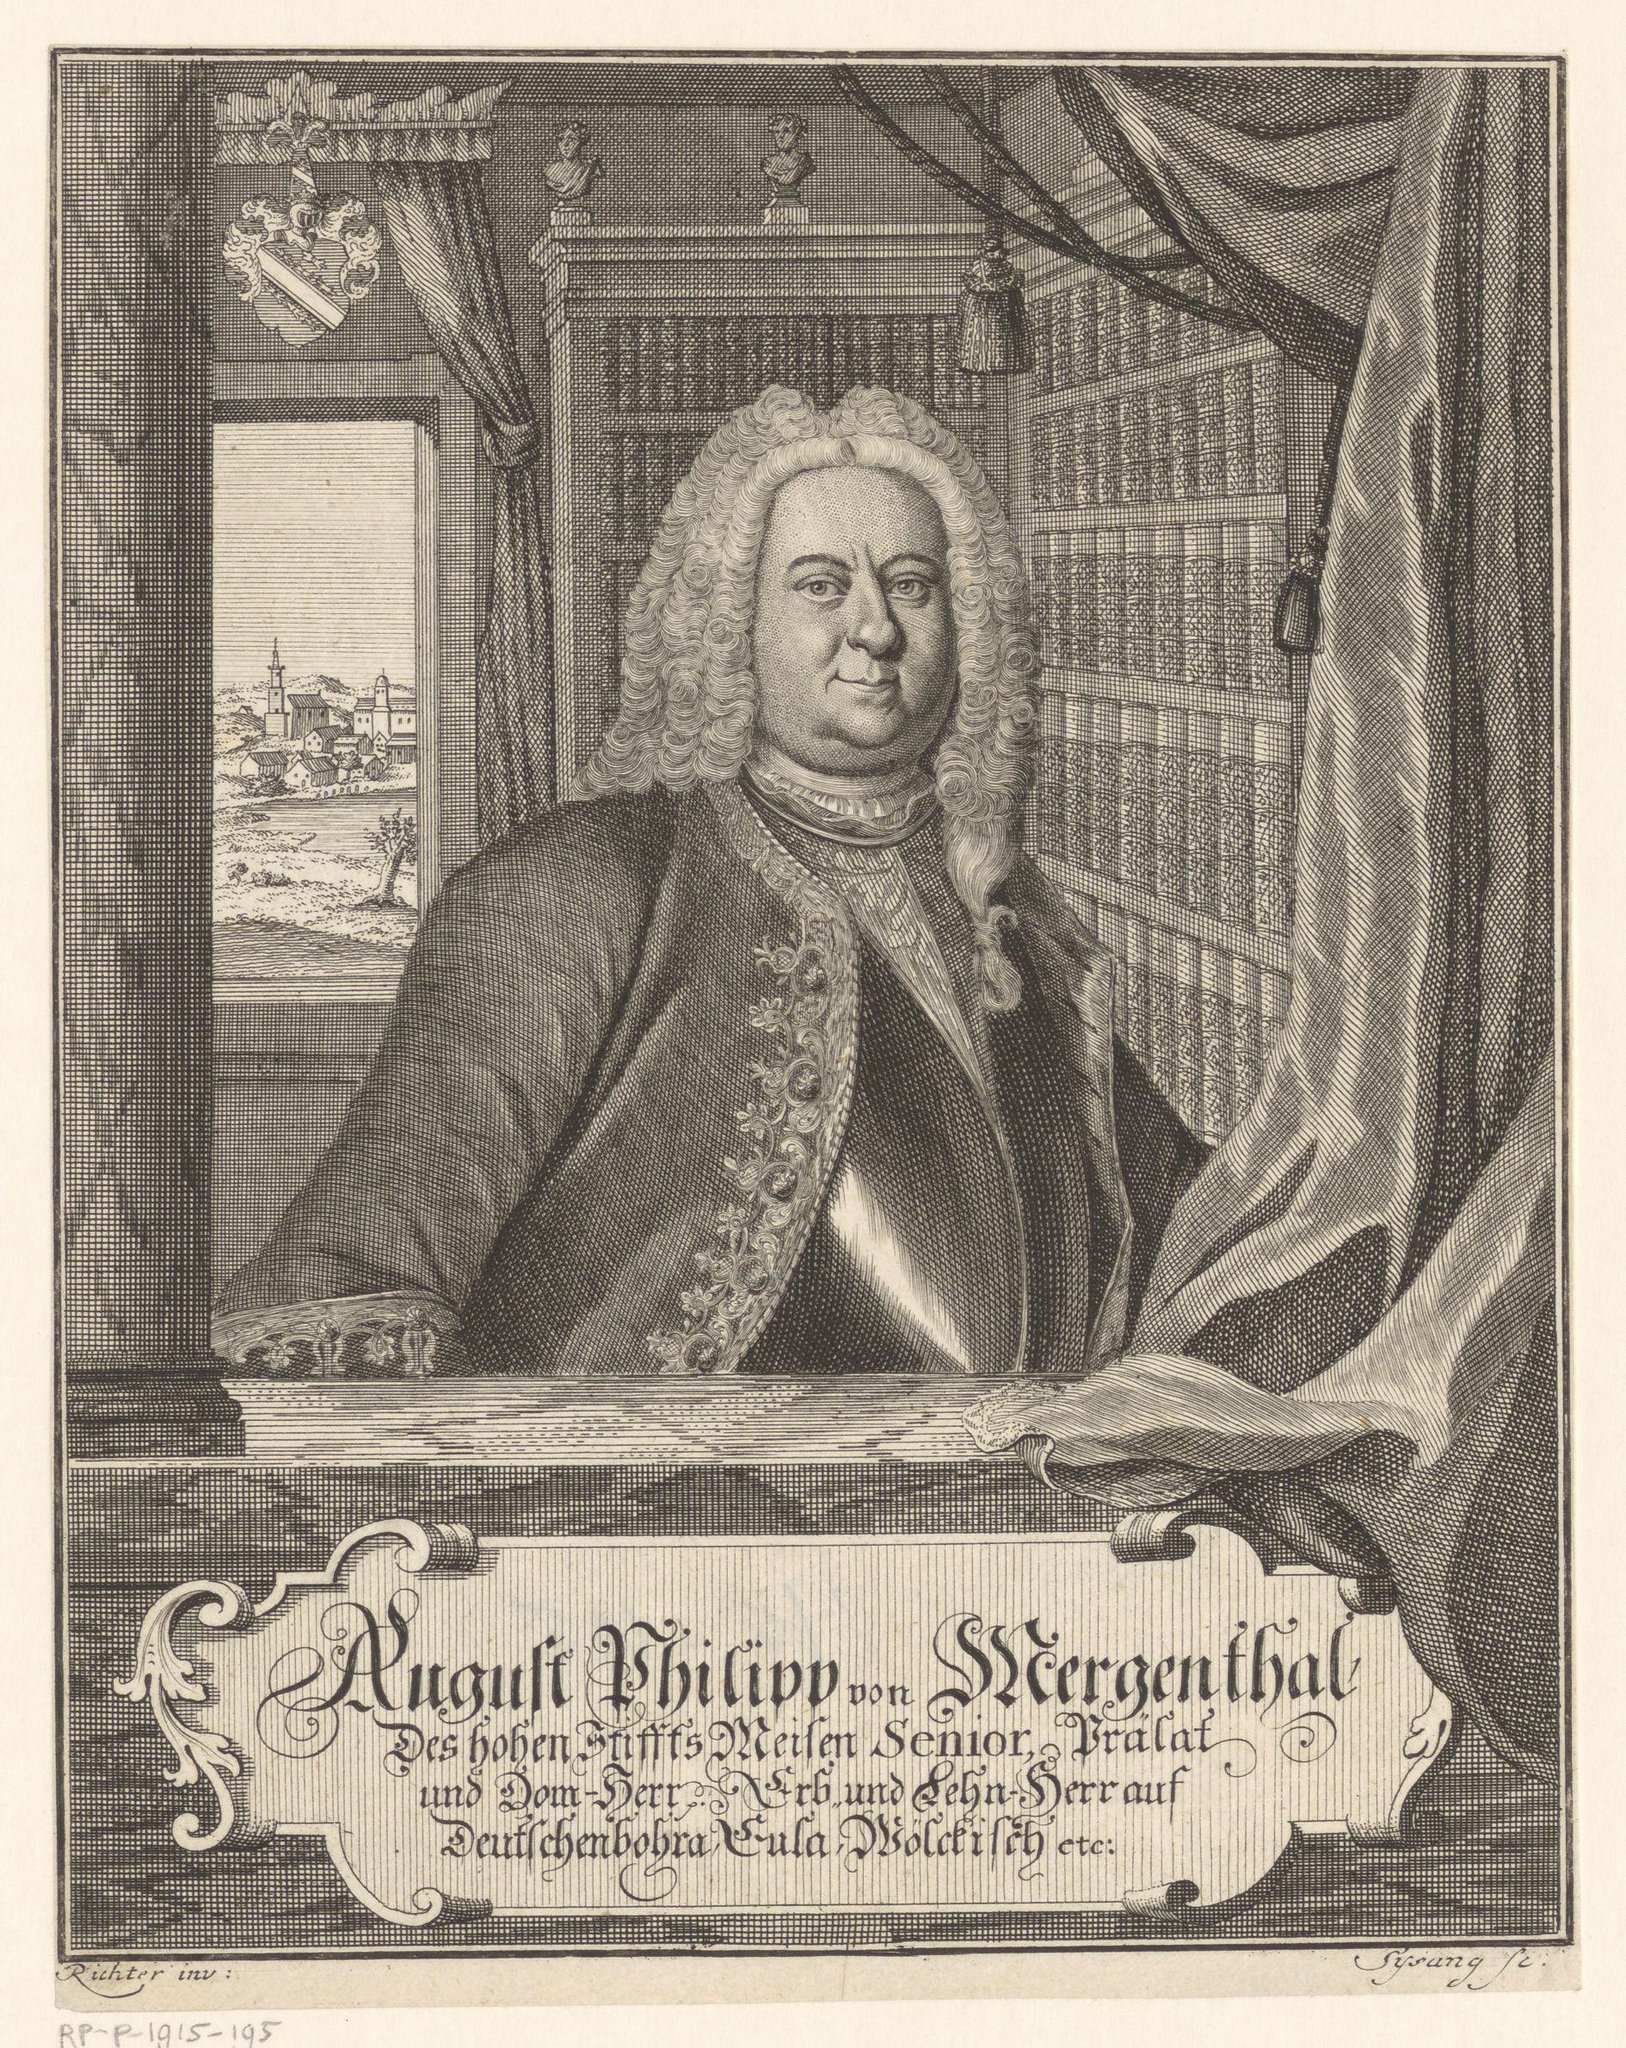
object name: print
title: Portret van August Philipp von Mergenthal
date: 1713-1757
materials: paper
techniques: engraving, etching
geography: germany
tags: bookshelves, historical persons, armorial bearing, heraldry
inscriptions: collector's mark: Lugt 2228